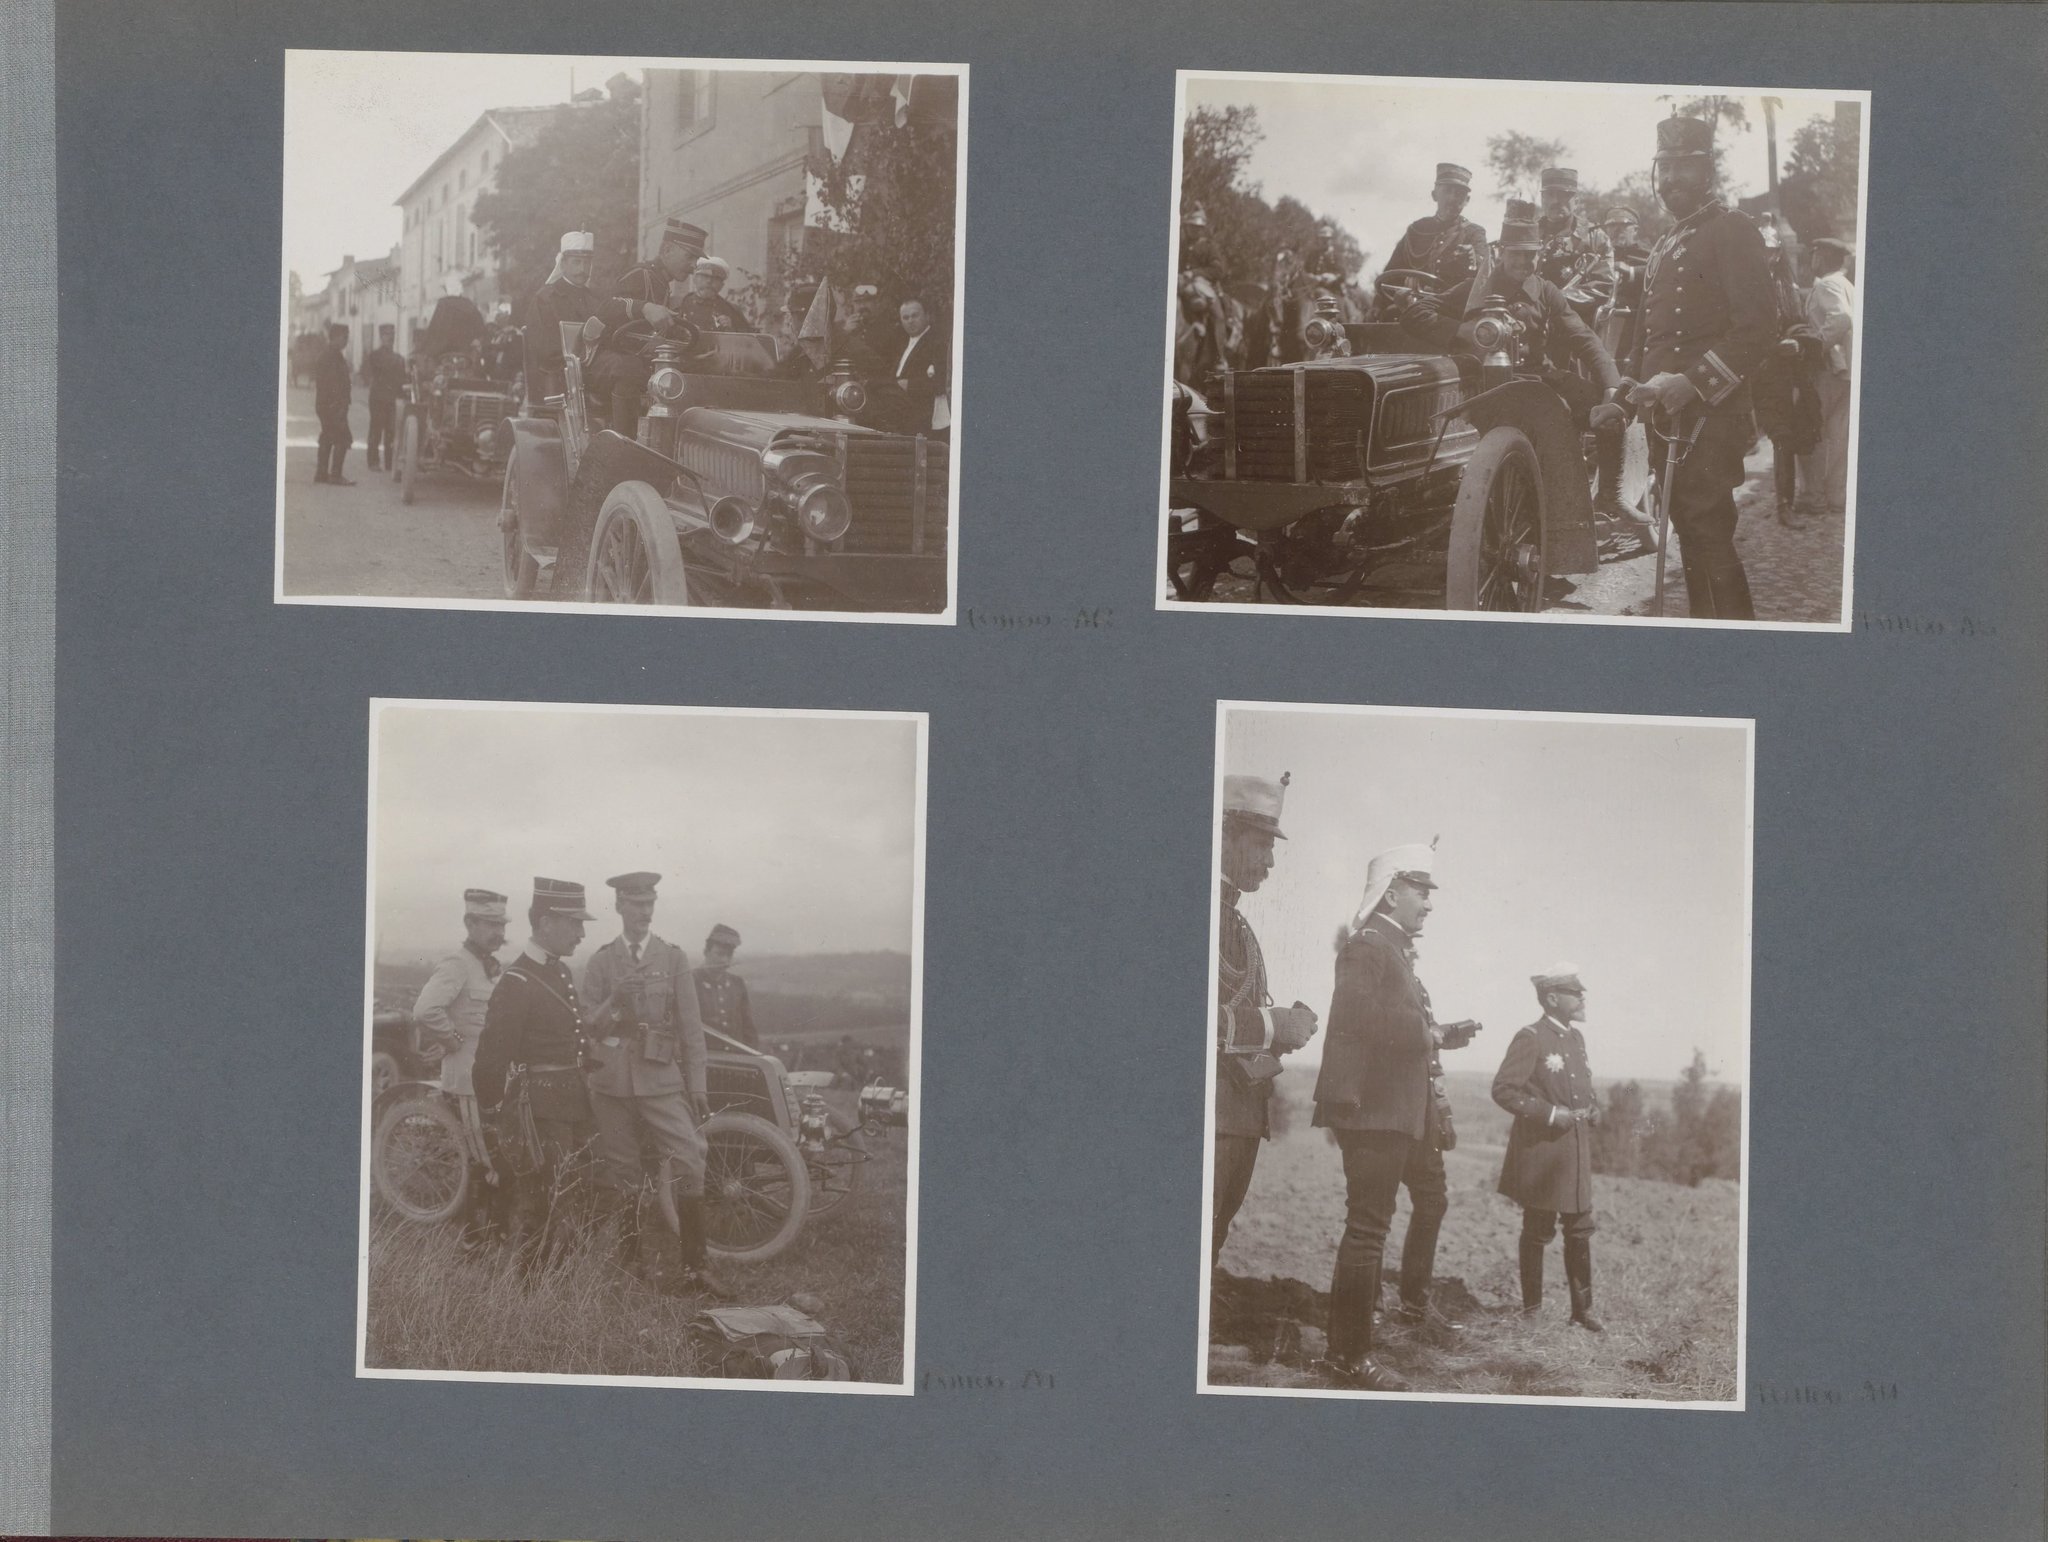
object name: album leaf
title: Militairen waaronder mogelijk een buitenlandse waarnemer bij een auto in Frankrijk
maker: Anonymous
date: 1902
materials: paper, photographic support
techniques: daylight paper print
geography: france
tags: manoeuvre ~ military training, land forces, automobile, france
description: Onderdeel van Fotoalbum van een legeroefening in Zuidwest-Frankrijk in 1902.